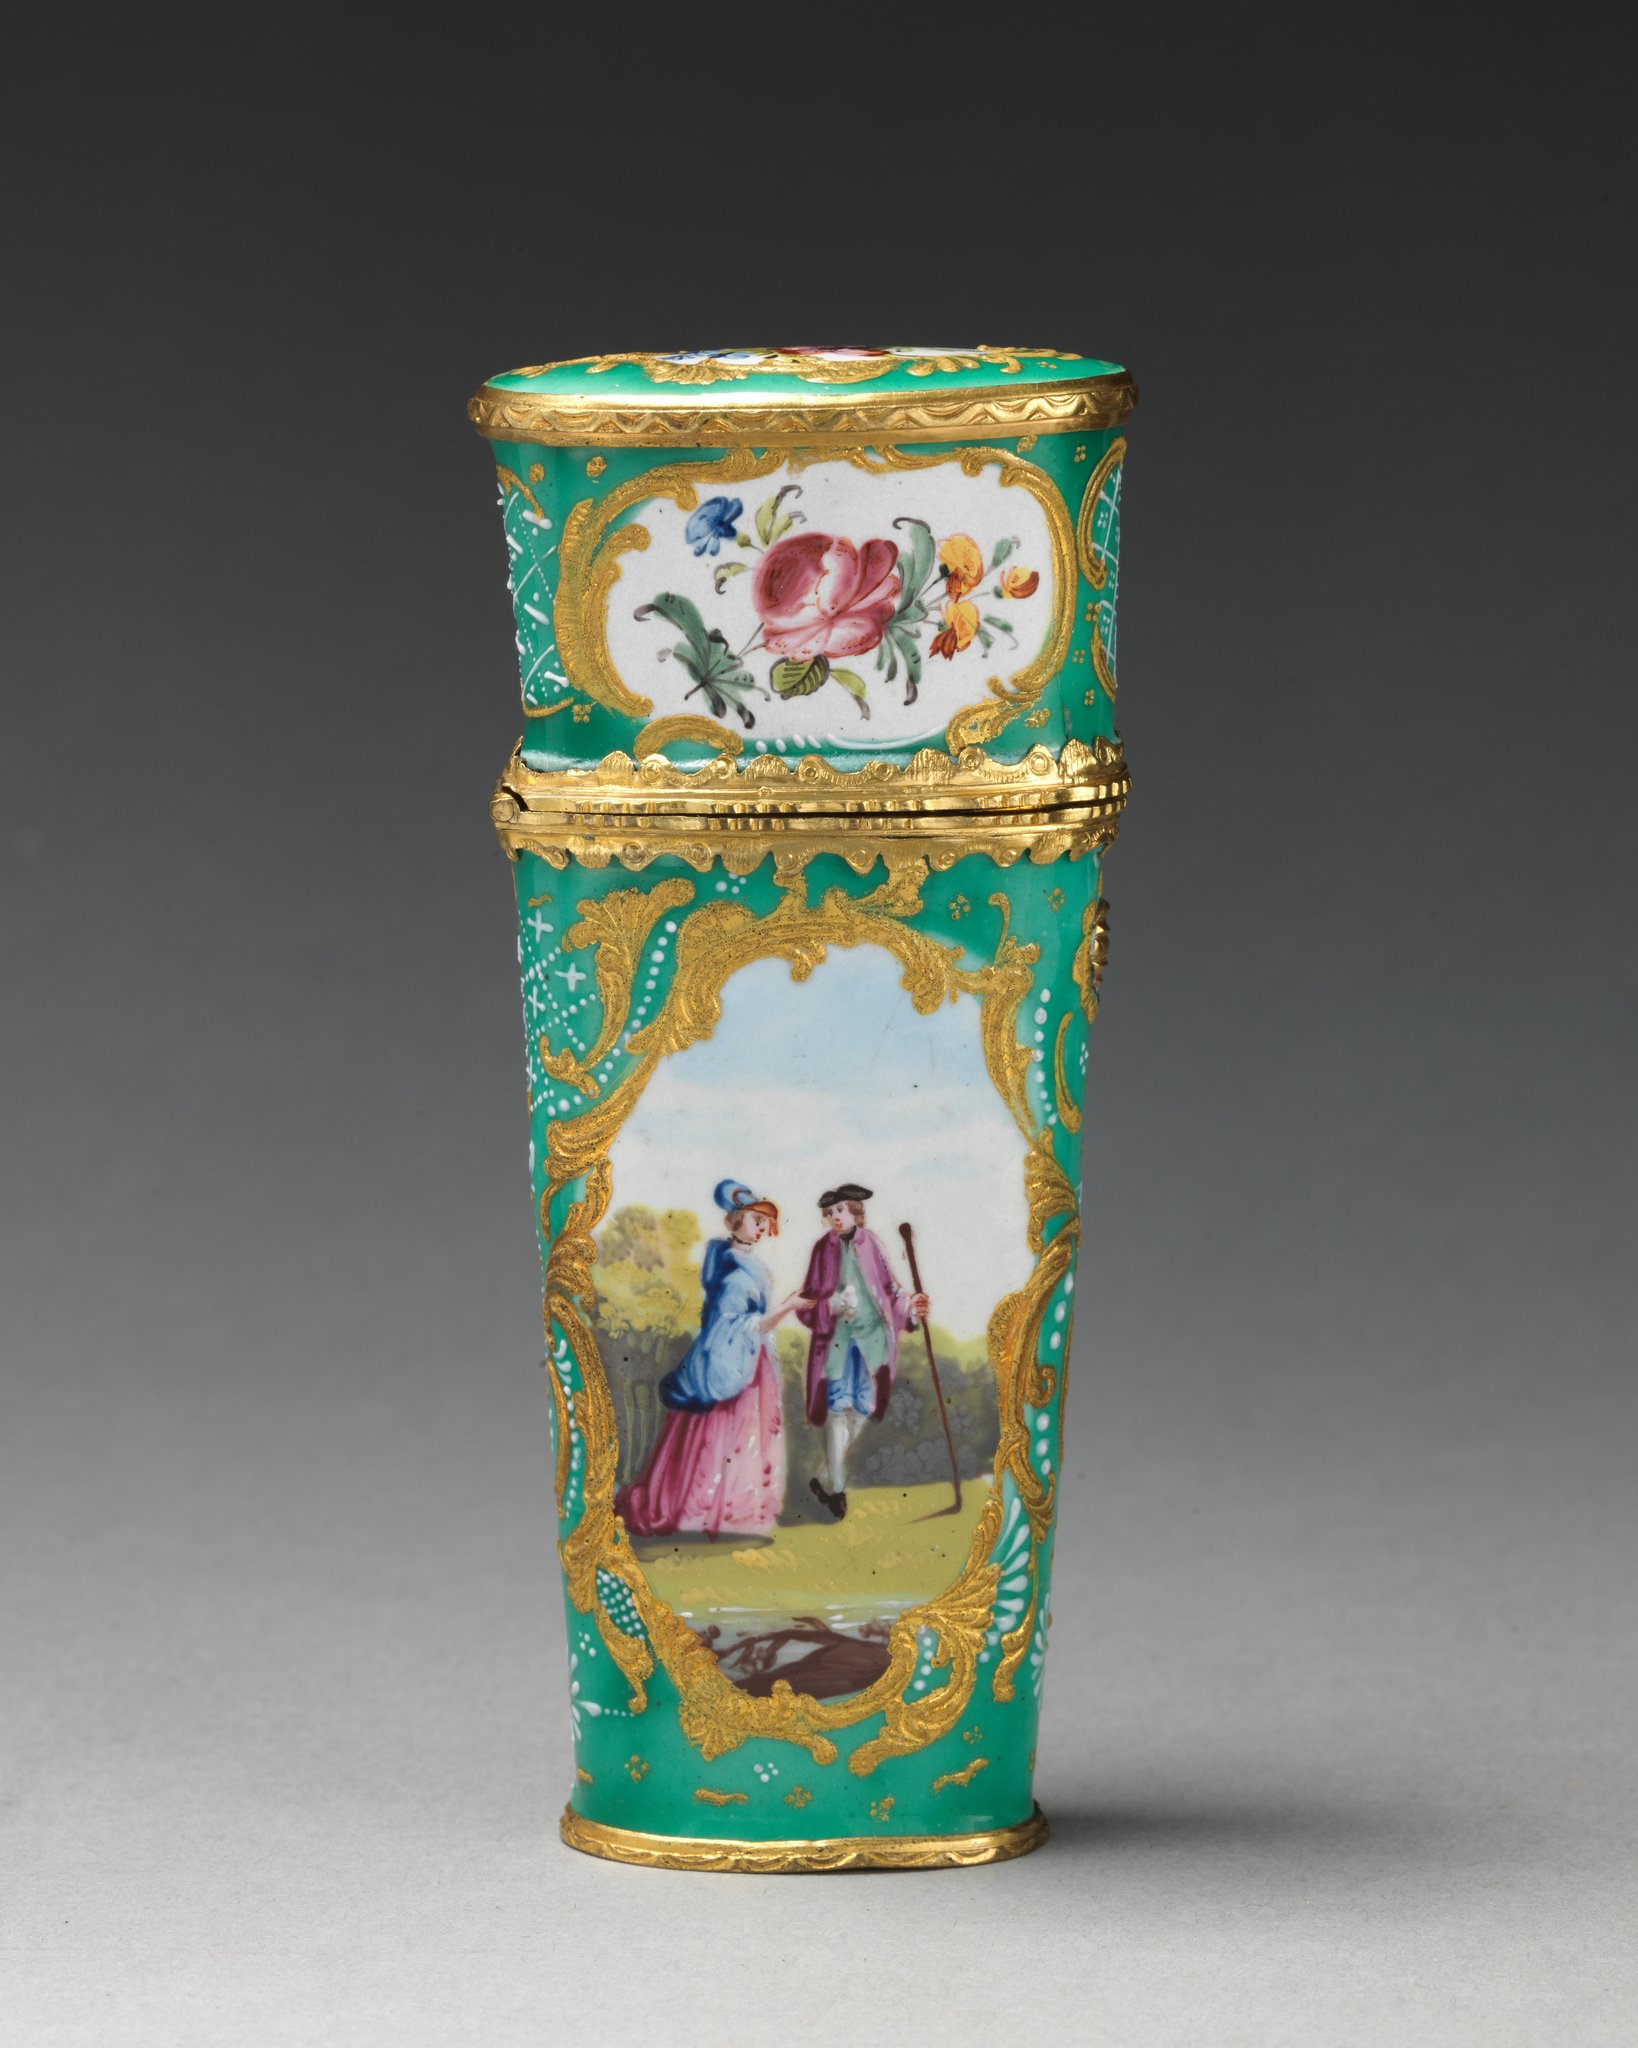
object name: étui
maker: robert sayer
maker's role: publisher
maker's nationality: british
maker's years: 1725-1794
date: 1765-1770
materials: copper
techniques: enamel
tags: human figures,flowers,boats